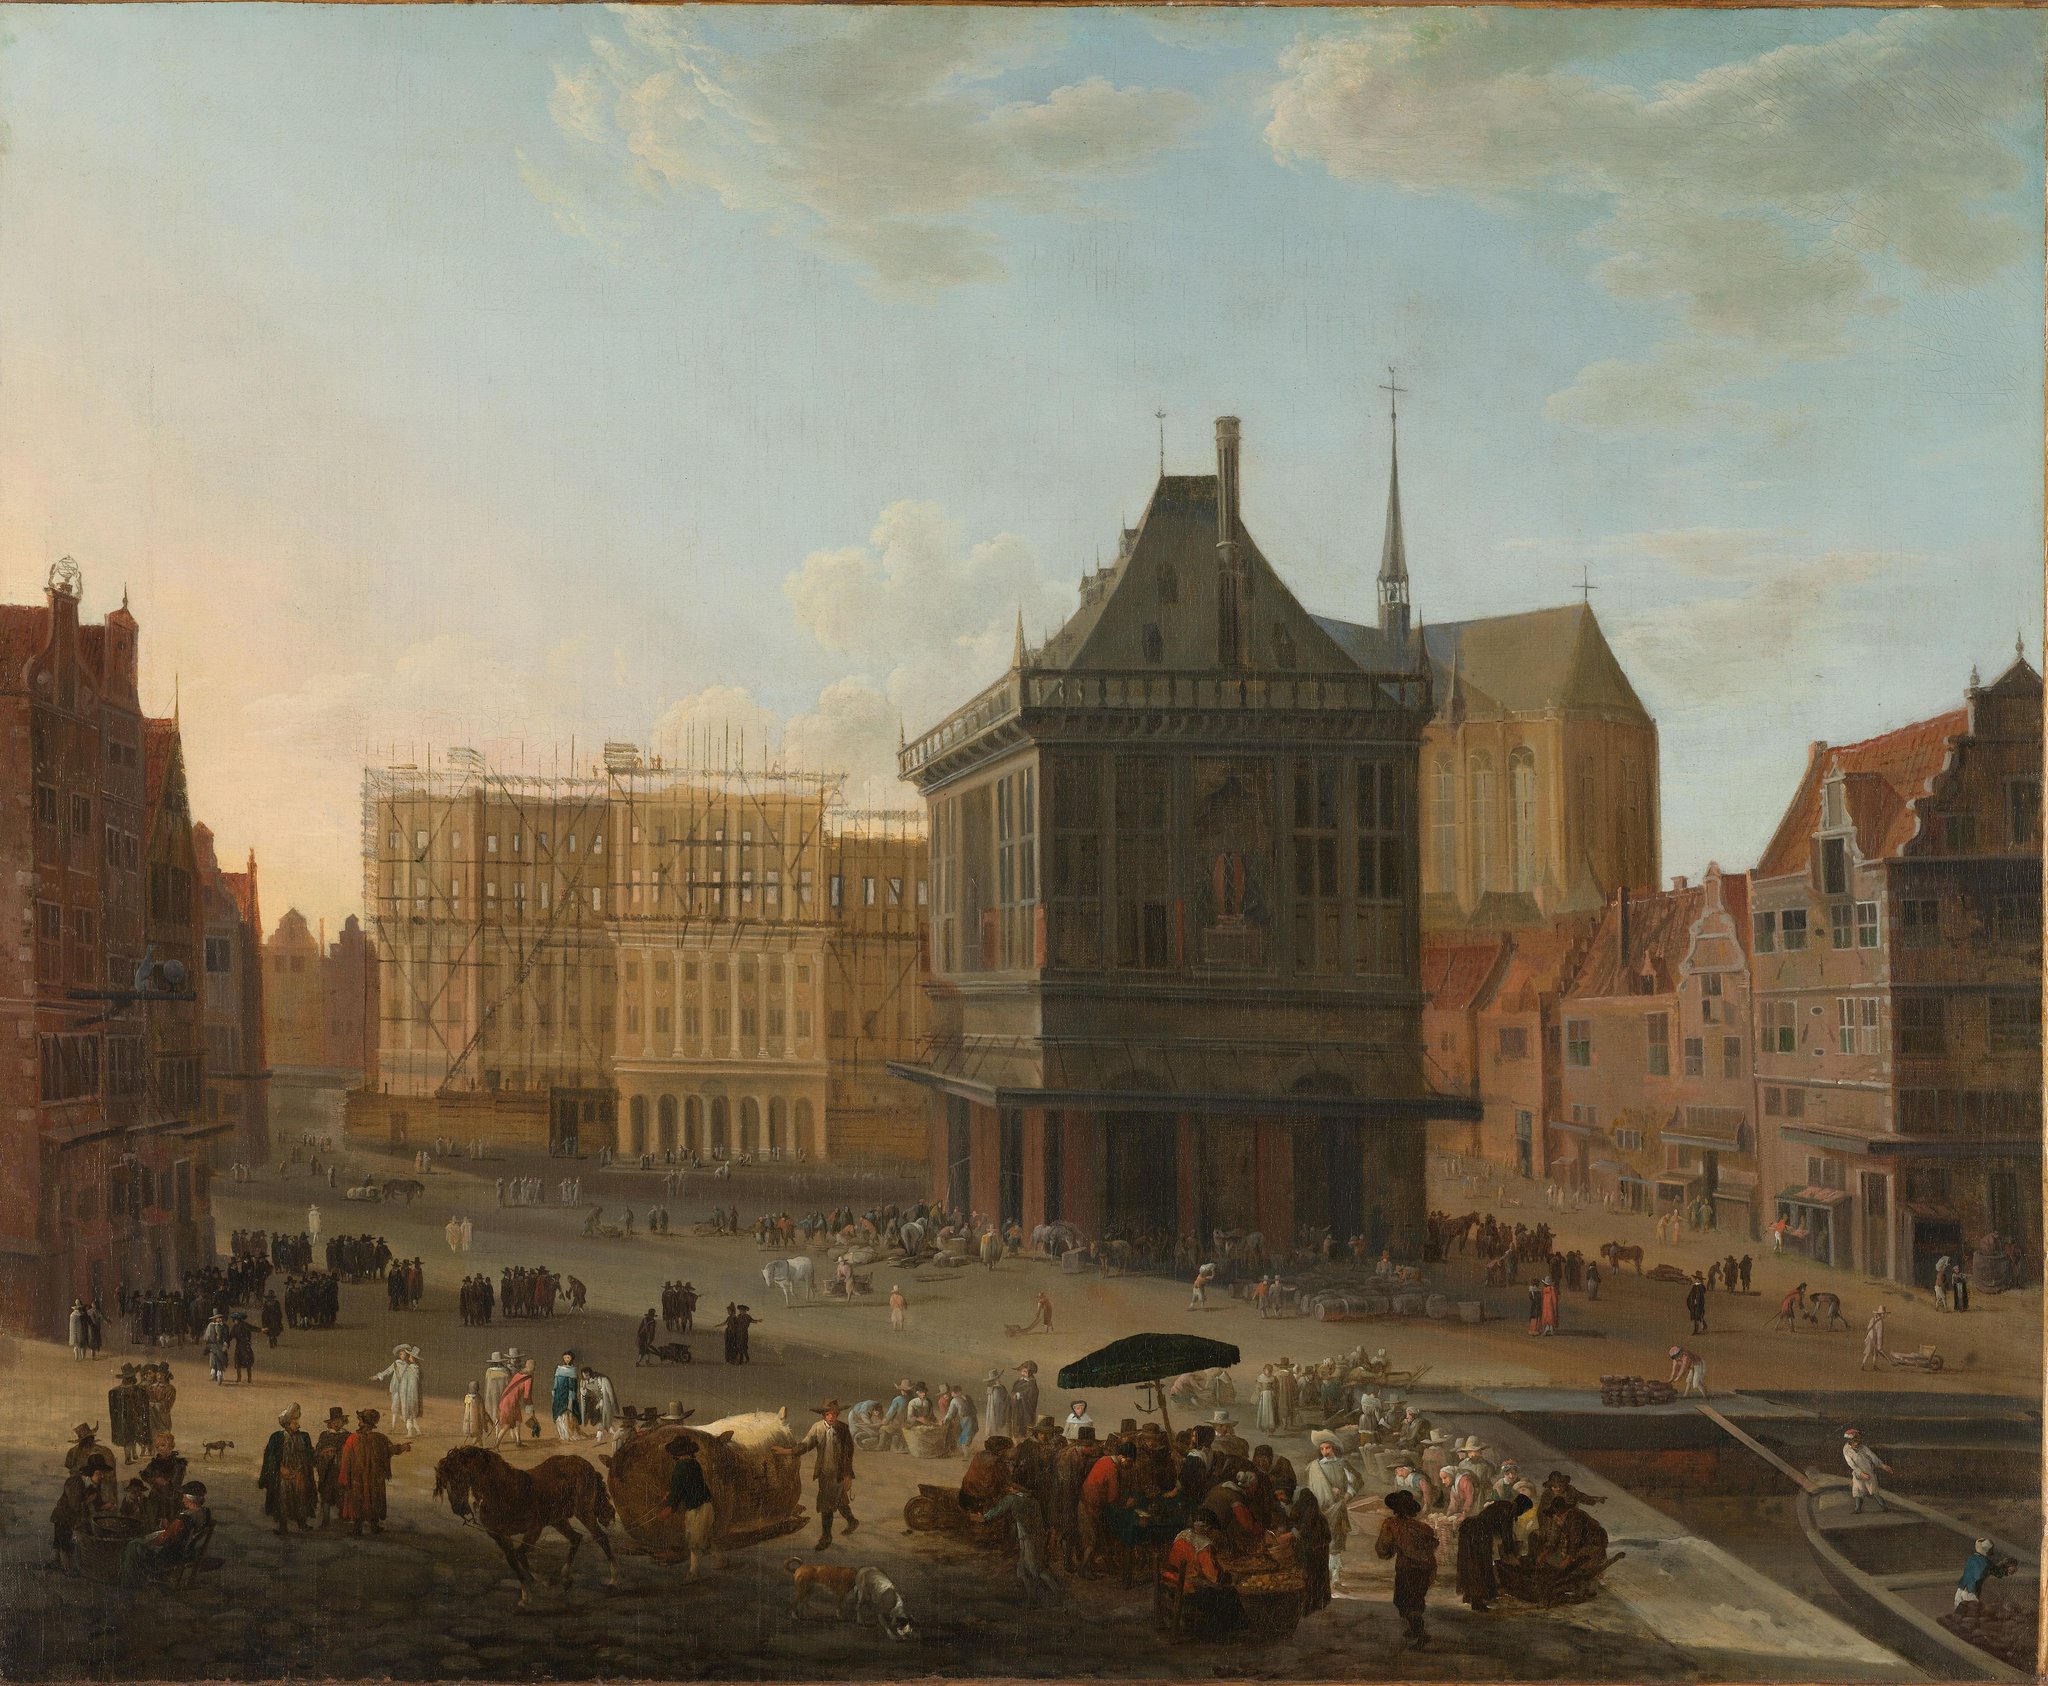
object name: painting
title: The Dam in Amsterdam with the new Town Hall under Construction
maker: jacob van der ulft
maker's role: draughtsman, painter, print maker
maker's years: 1627-1689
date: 1652-1689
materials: canvas, oil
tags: square, place, circus, etc., making the overground structures (~ building activities), animal-drawn sledge (dutch: 'toeslede'), weigh-house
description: Stadsgezicht met de Dam te Amsterdam met het nieuwe stadhuis in aanbouw, het Waaggebouw en de Nieuwe Kerk. Op de Dam en langs de kade verkopen handelaren hun waar.